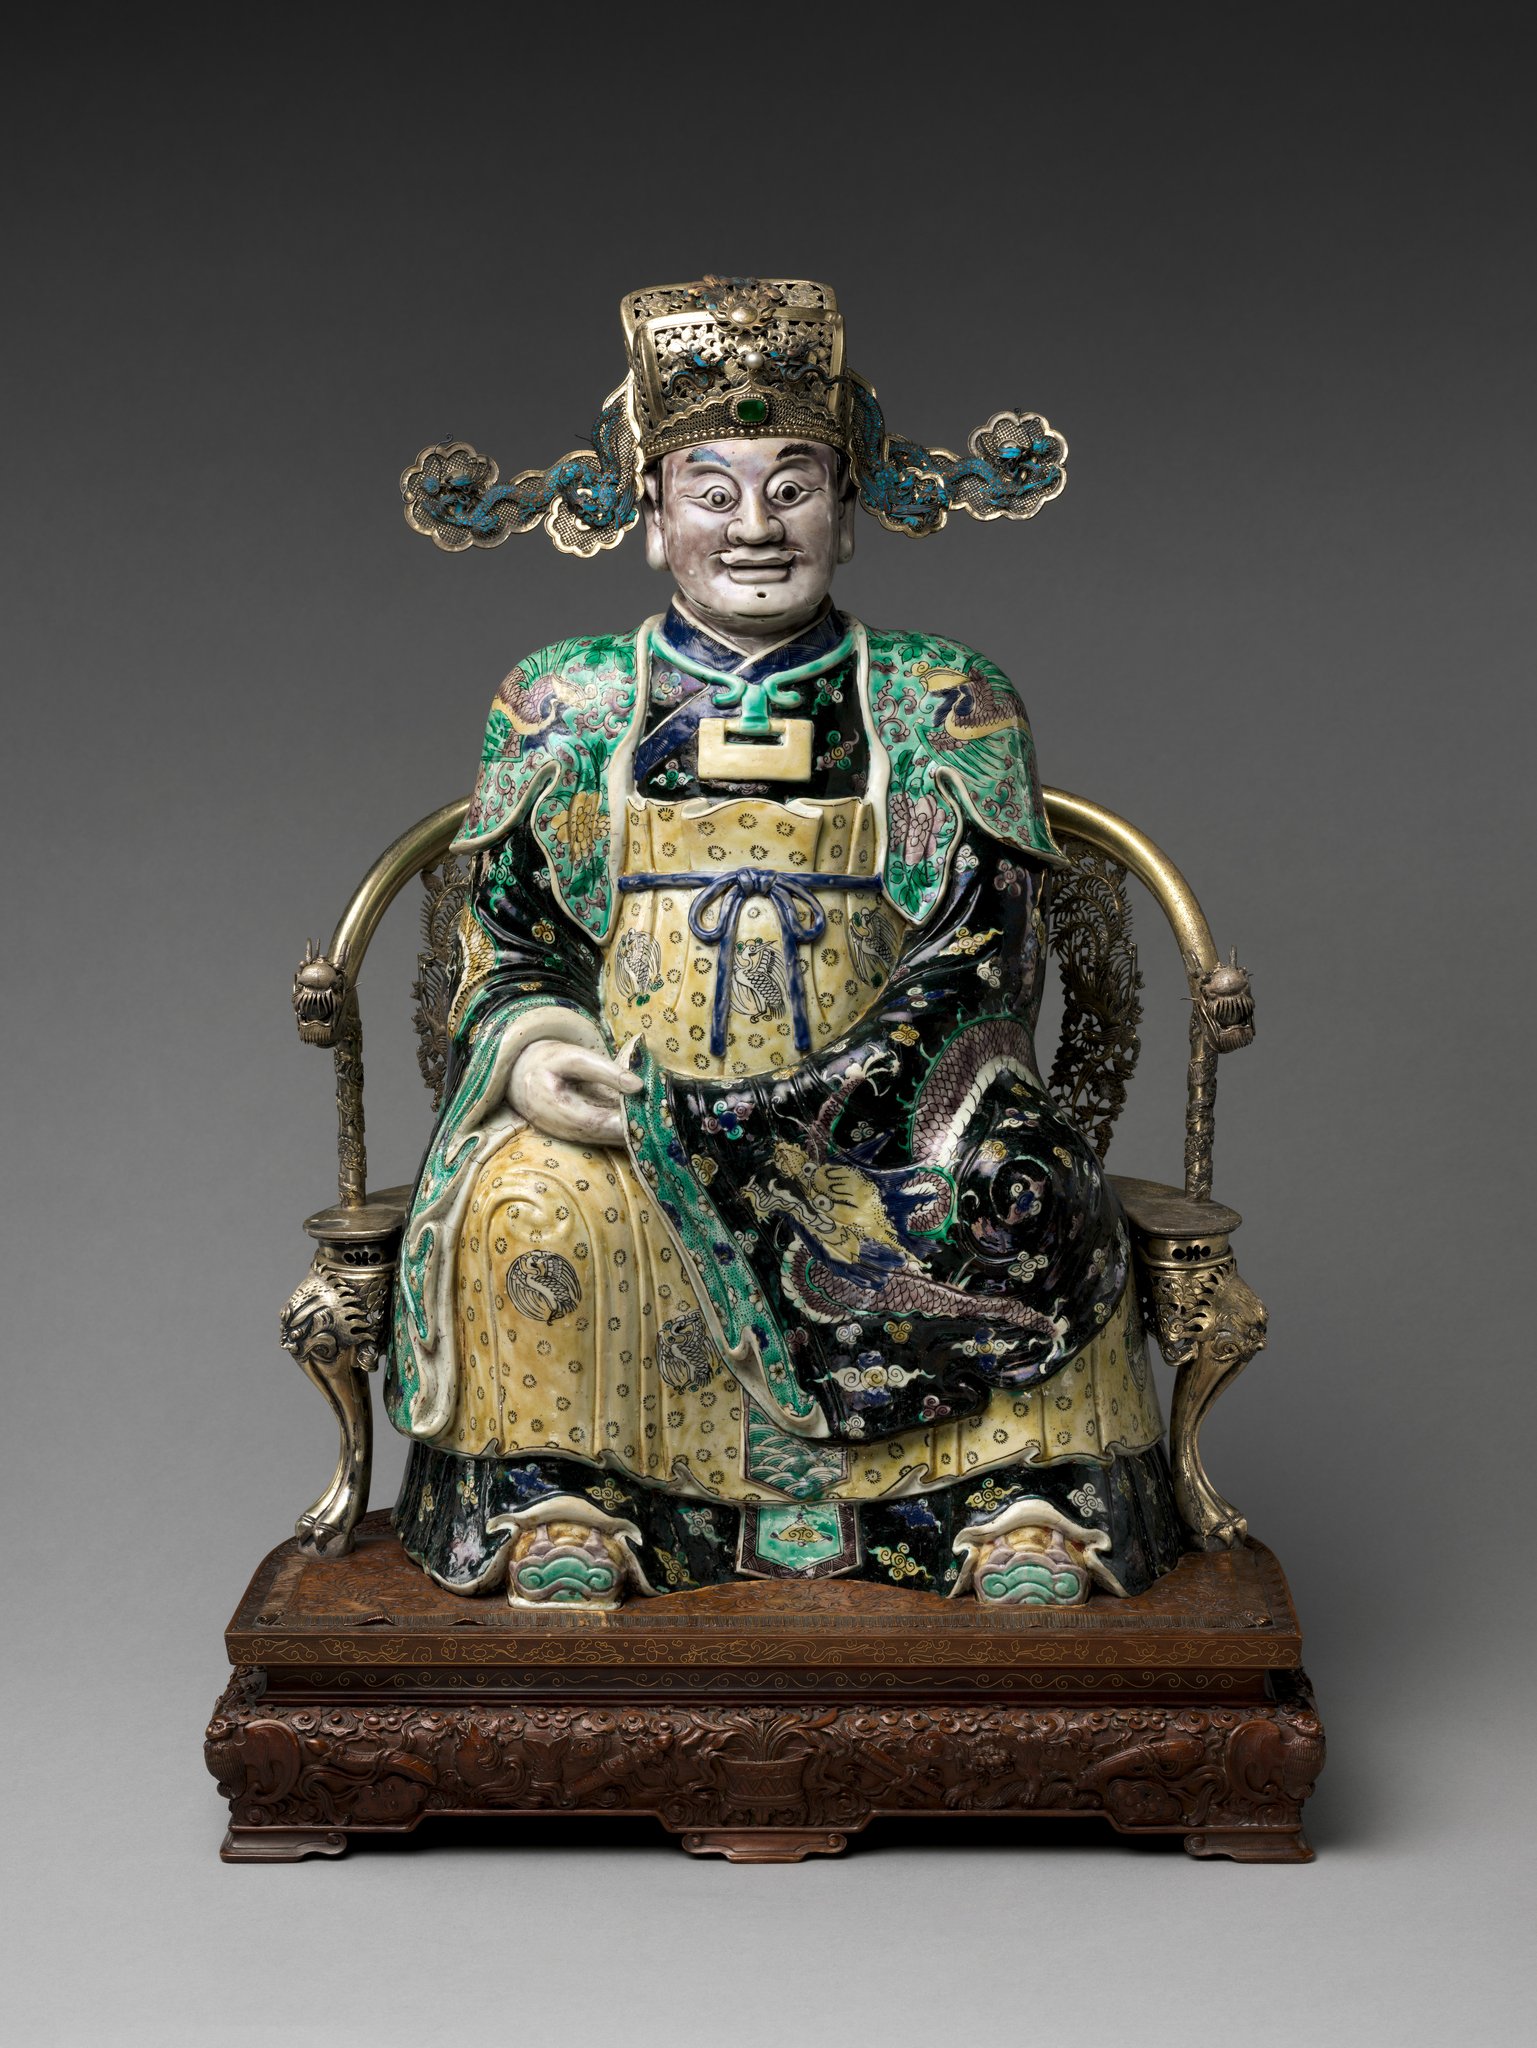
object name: figure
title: Figure, possibly the God of Wealth in His Military Aspect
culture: chinese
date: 1667-1733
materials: biscuit, enamel, porcelain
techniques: painting